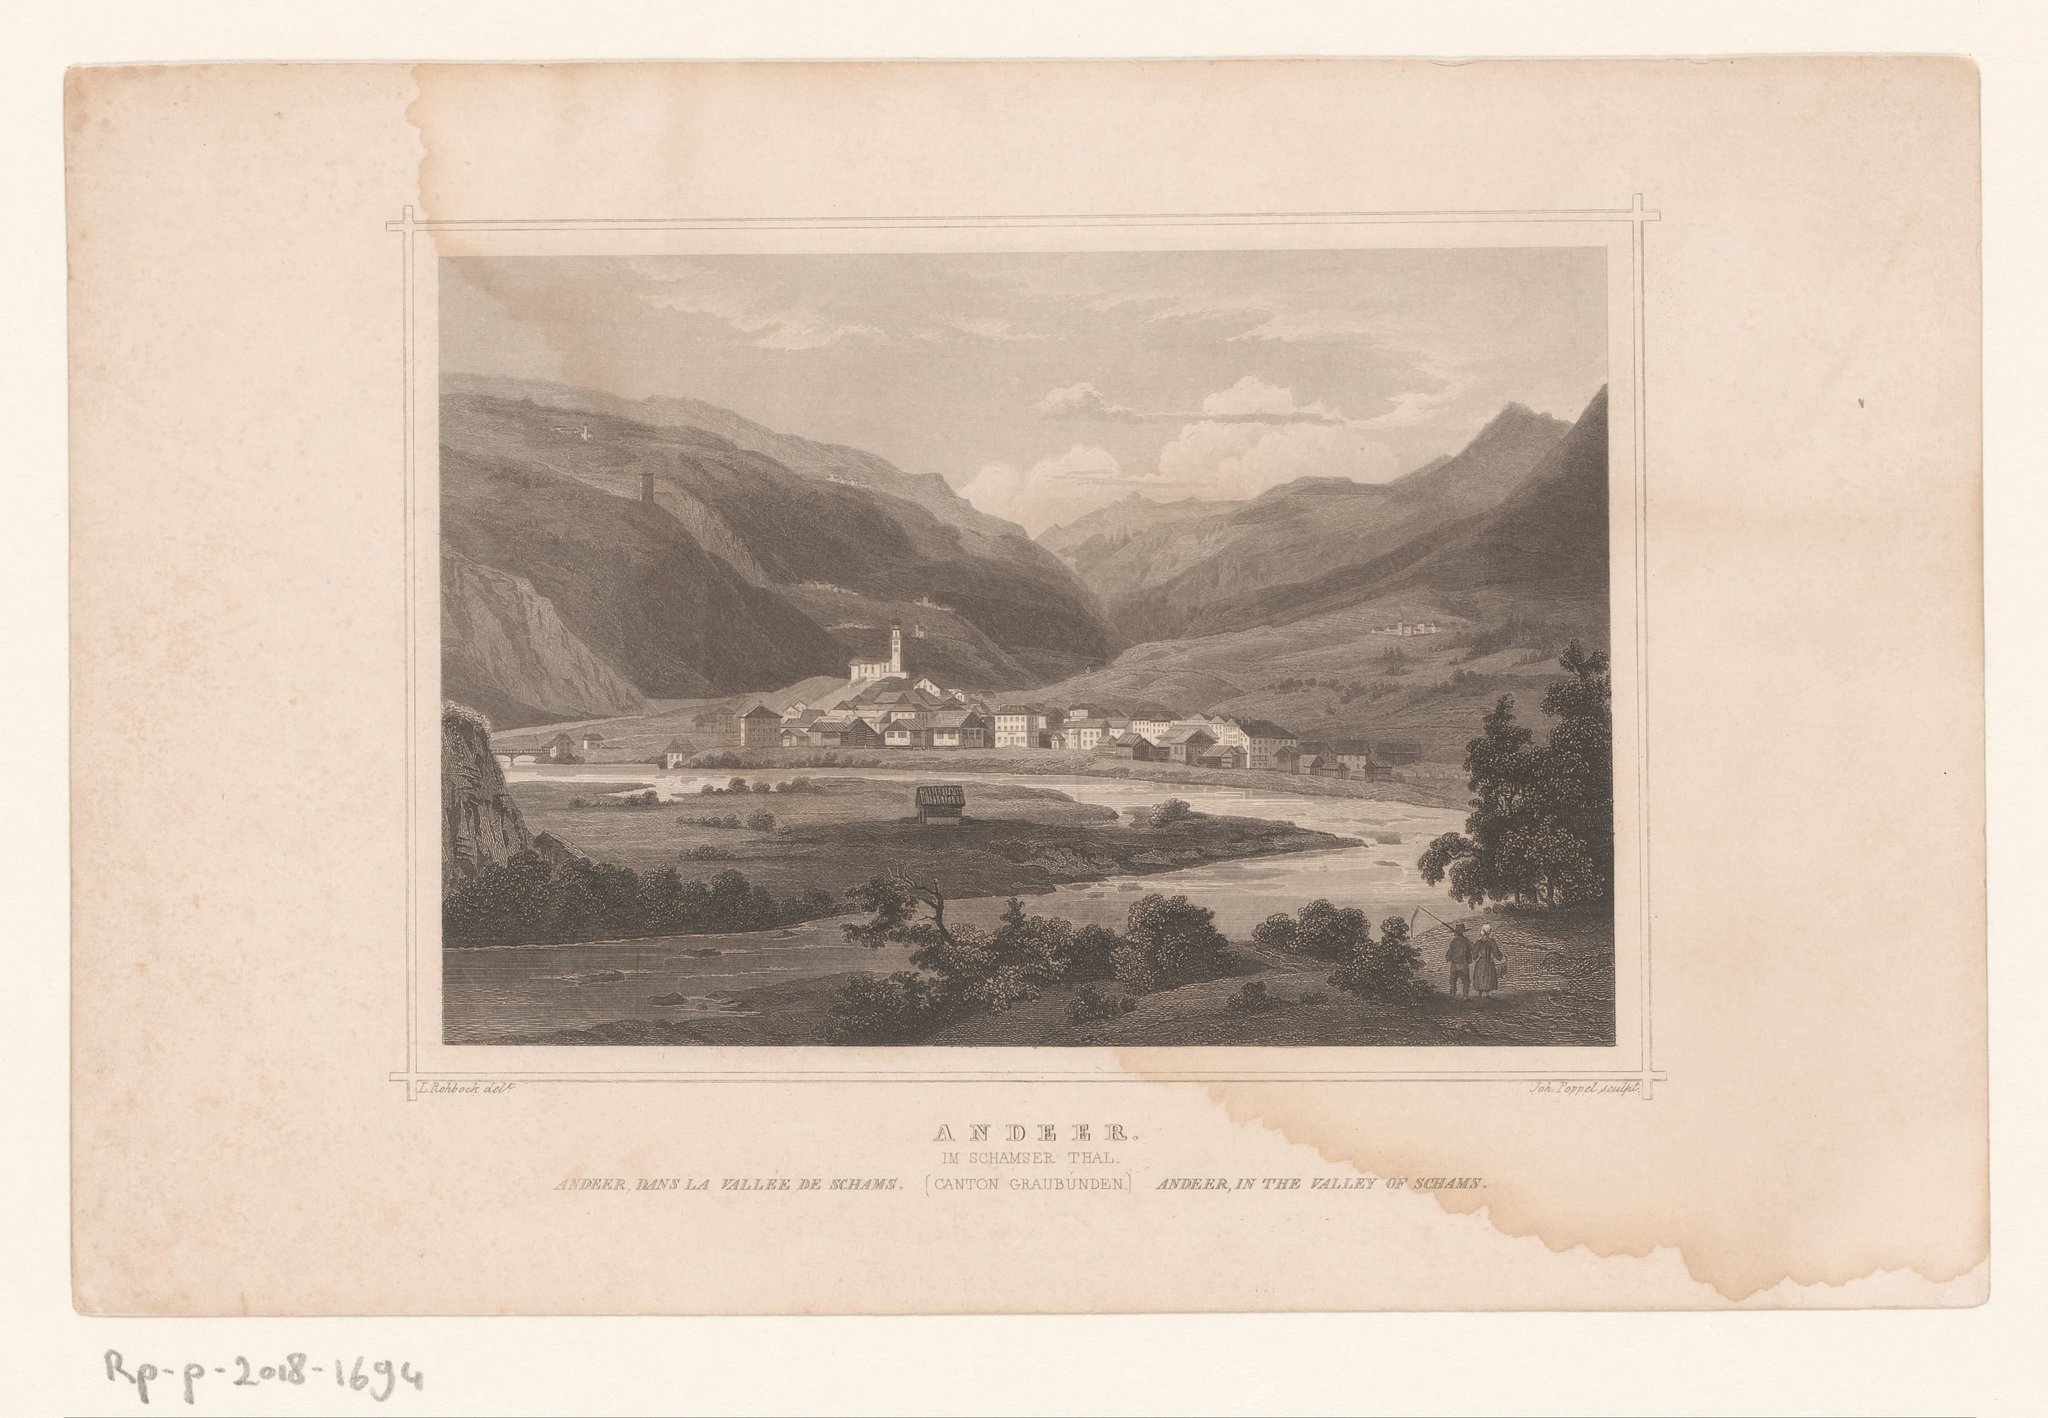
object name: print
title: Gezicht op Andeer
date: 1834-1882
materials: paper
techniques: engraving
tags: prospect of village, silhouette of village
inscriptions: collector's mark: Lugt 2228